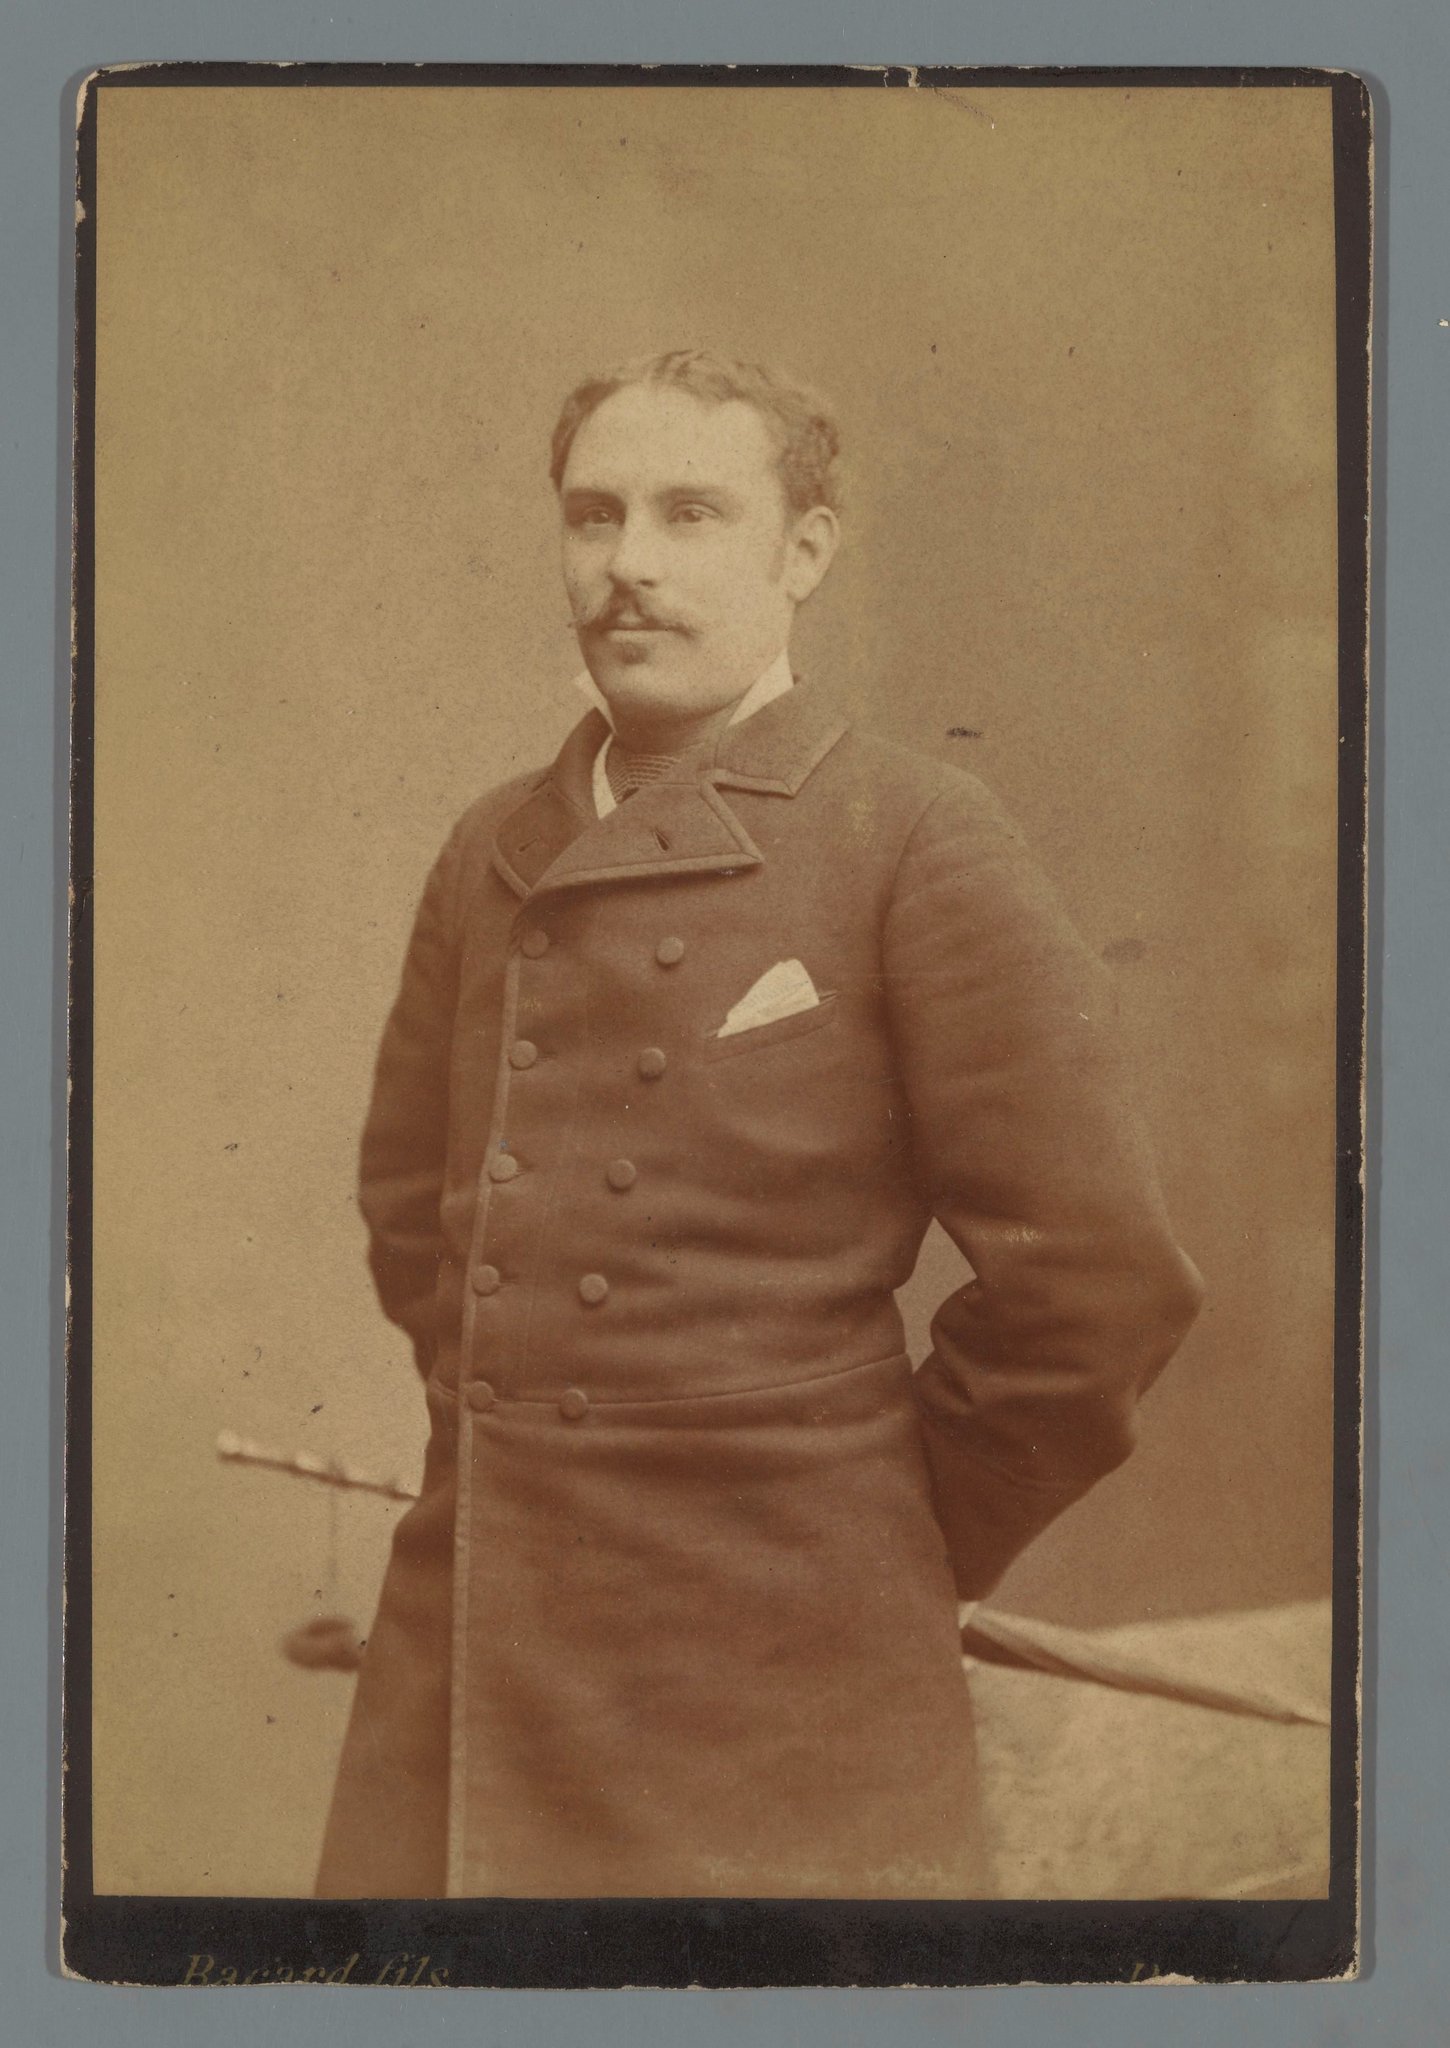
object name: cabinet photograph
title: Portret van een onbekende man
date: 1880-1900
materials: cardboard, photographic support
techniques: albumen print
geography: paris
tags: adult man, umbrella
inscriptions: name: ‘Photographie d'Art médaille d'argent Bacard Fils Paris expon Universelle 31, Boulevard Bonne Nouvelle, 31 en face le théatre du Gymnase Paris’